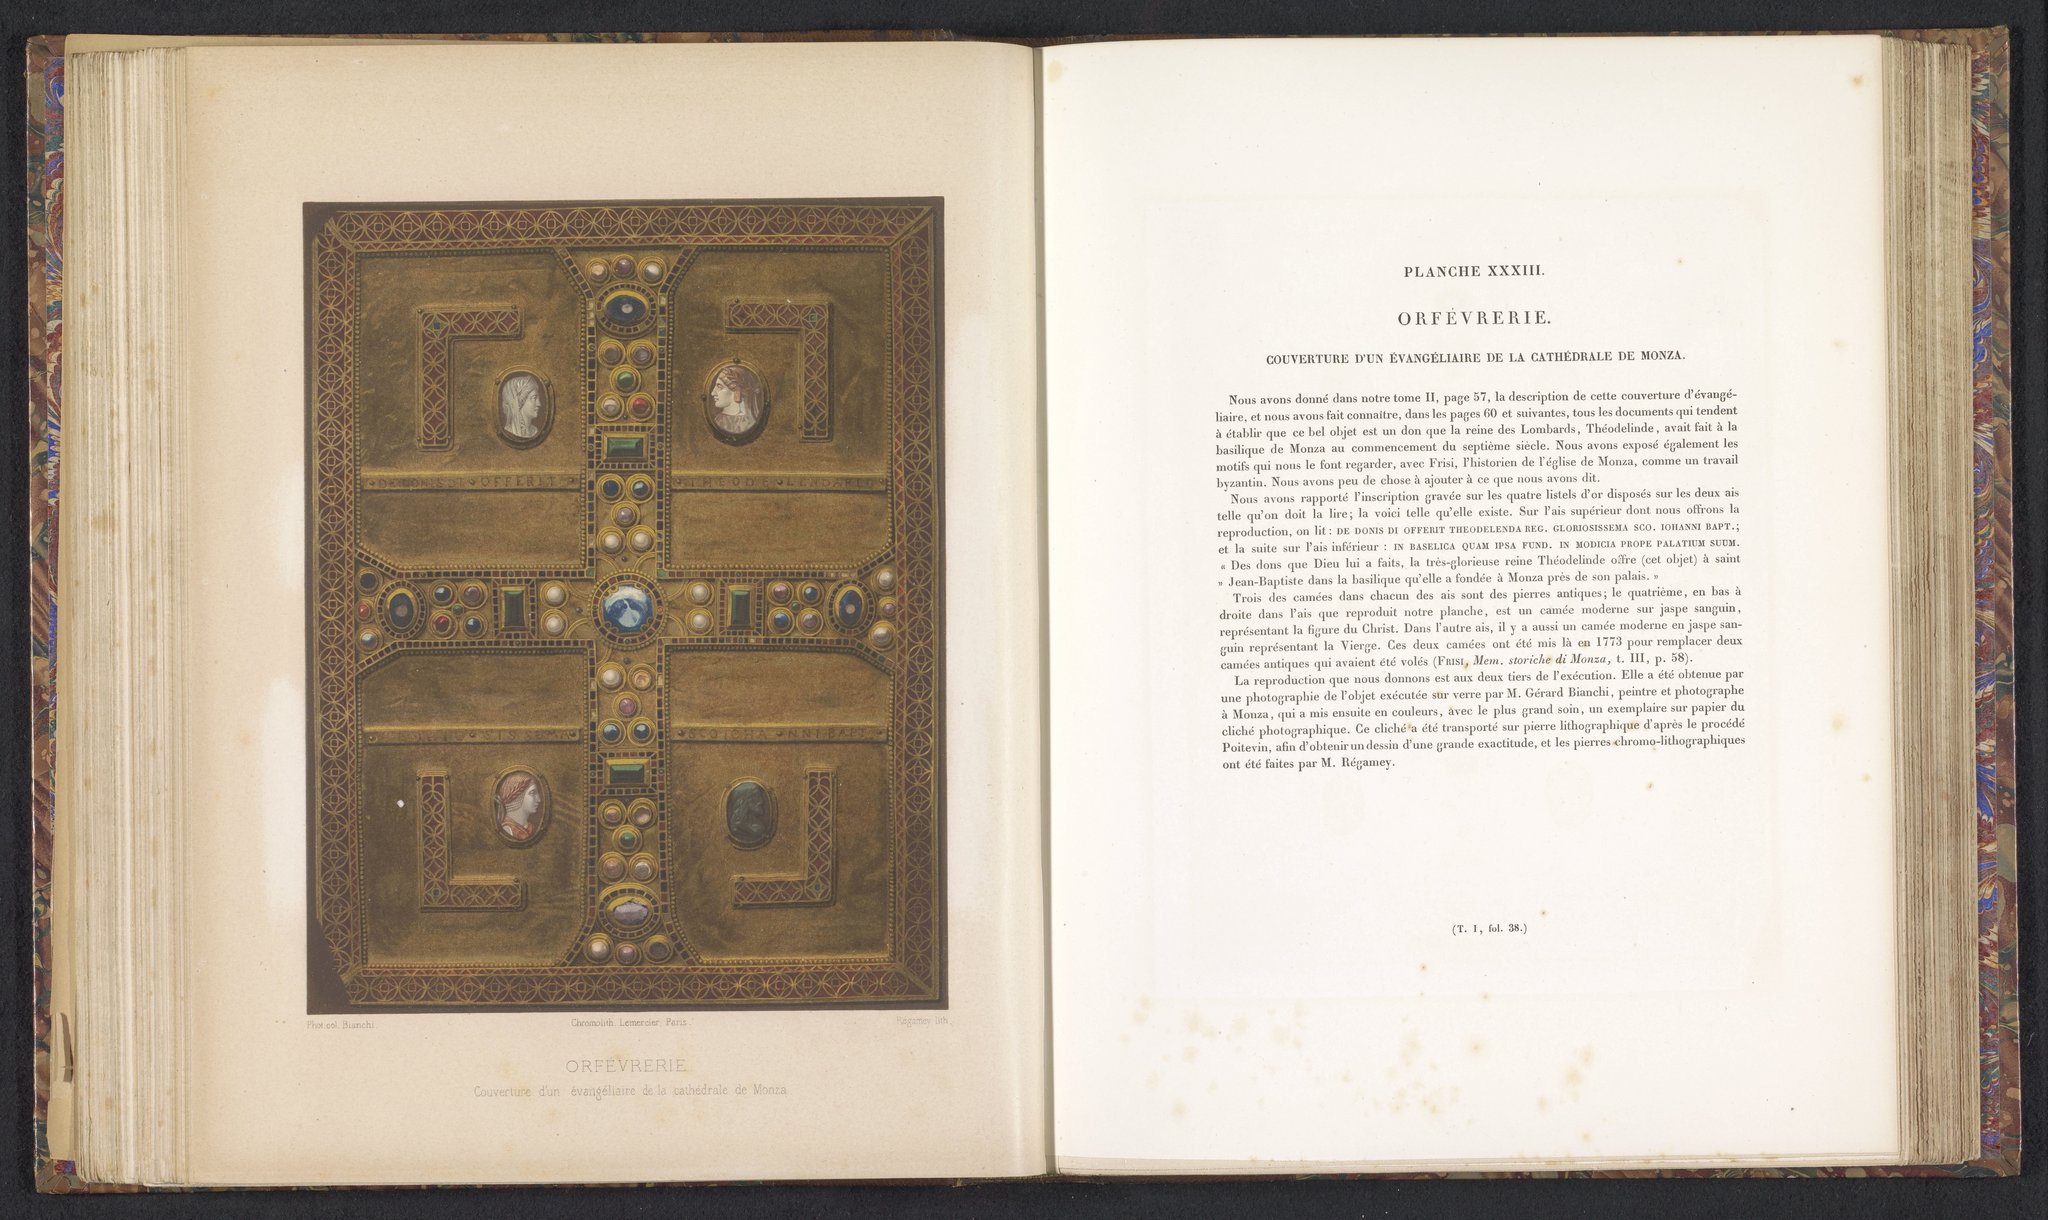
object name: print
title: Kaft van een evangeliarium, afkomstig uit de Kathedraal van Monza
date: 1859-1864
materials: paper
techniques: chromolithography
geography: paris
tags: book-cover, binding